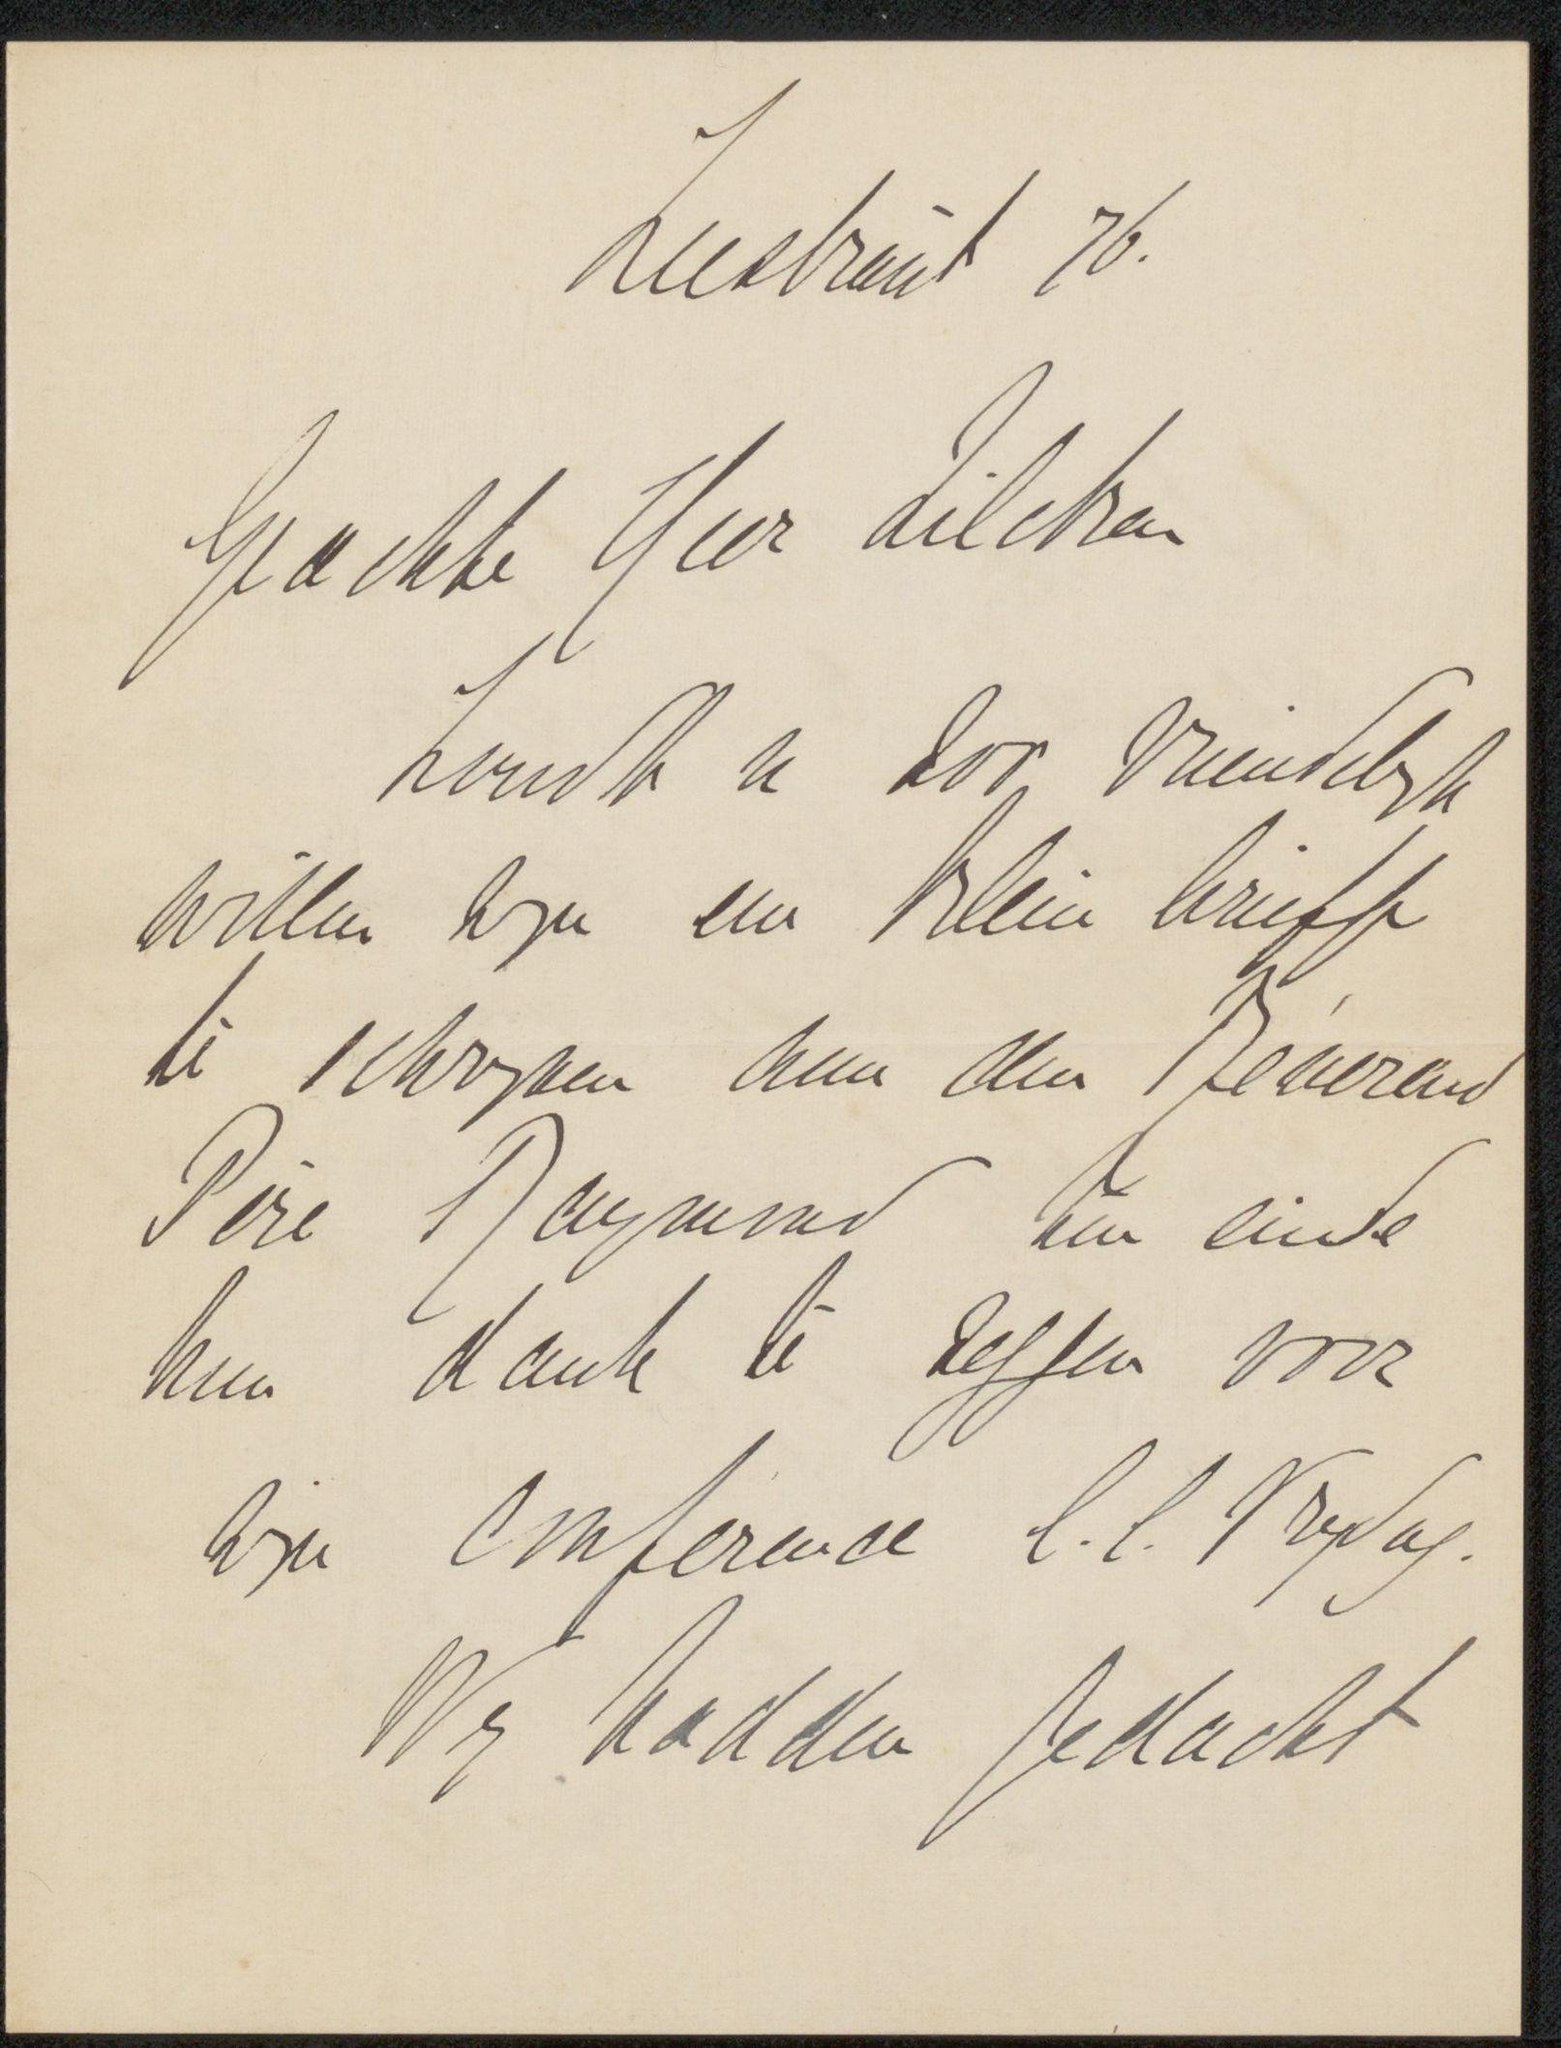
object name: letter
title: Brief aan Philip Zilcken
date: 1867-1930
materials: ink, paper, pencil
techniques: pen, writing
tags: painter, draughtsman, philip zilcken, money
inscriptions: collector's mark: ‘RPK’, watermark